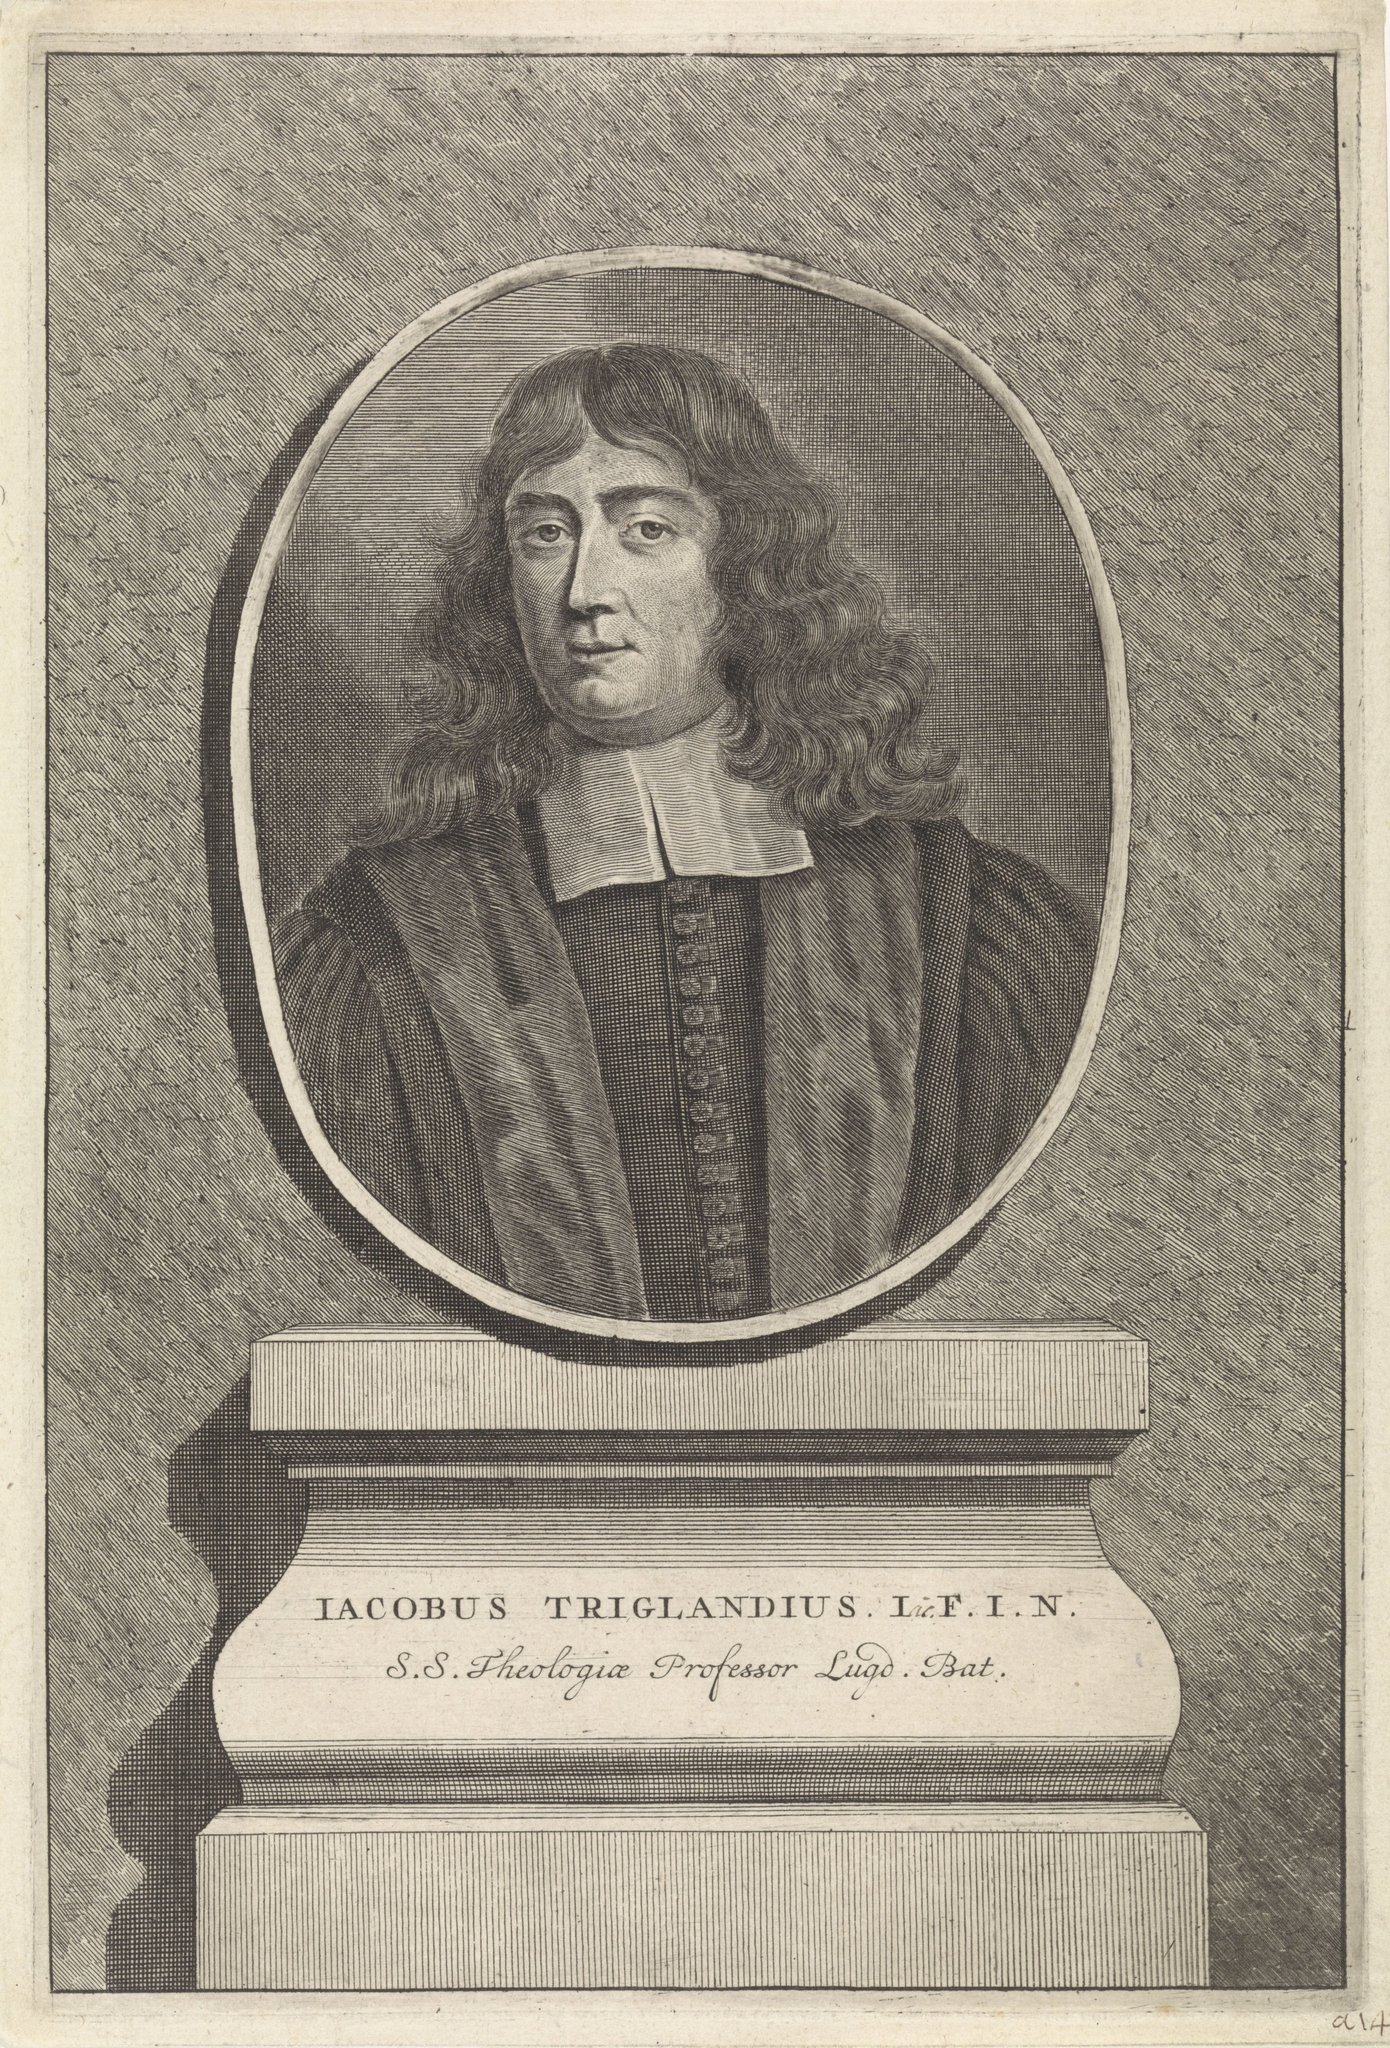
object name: print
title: Portret van Jacobus Trigland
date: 1687-1691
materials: paper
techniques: engraving, etching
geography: amsterdam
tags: haarlem, leiden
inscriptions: collector's mark: Lugt 2228, inscription: ‘a14’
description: Prent uit: XIX. Imagines Quorundam Clarissimorum Theologorum & Philologorum. Leiden: Pieter van der Aa (I), [c. 1720].